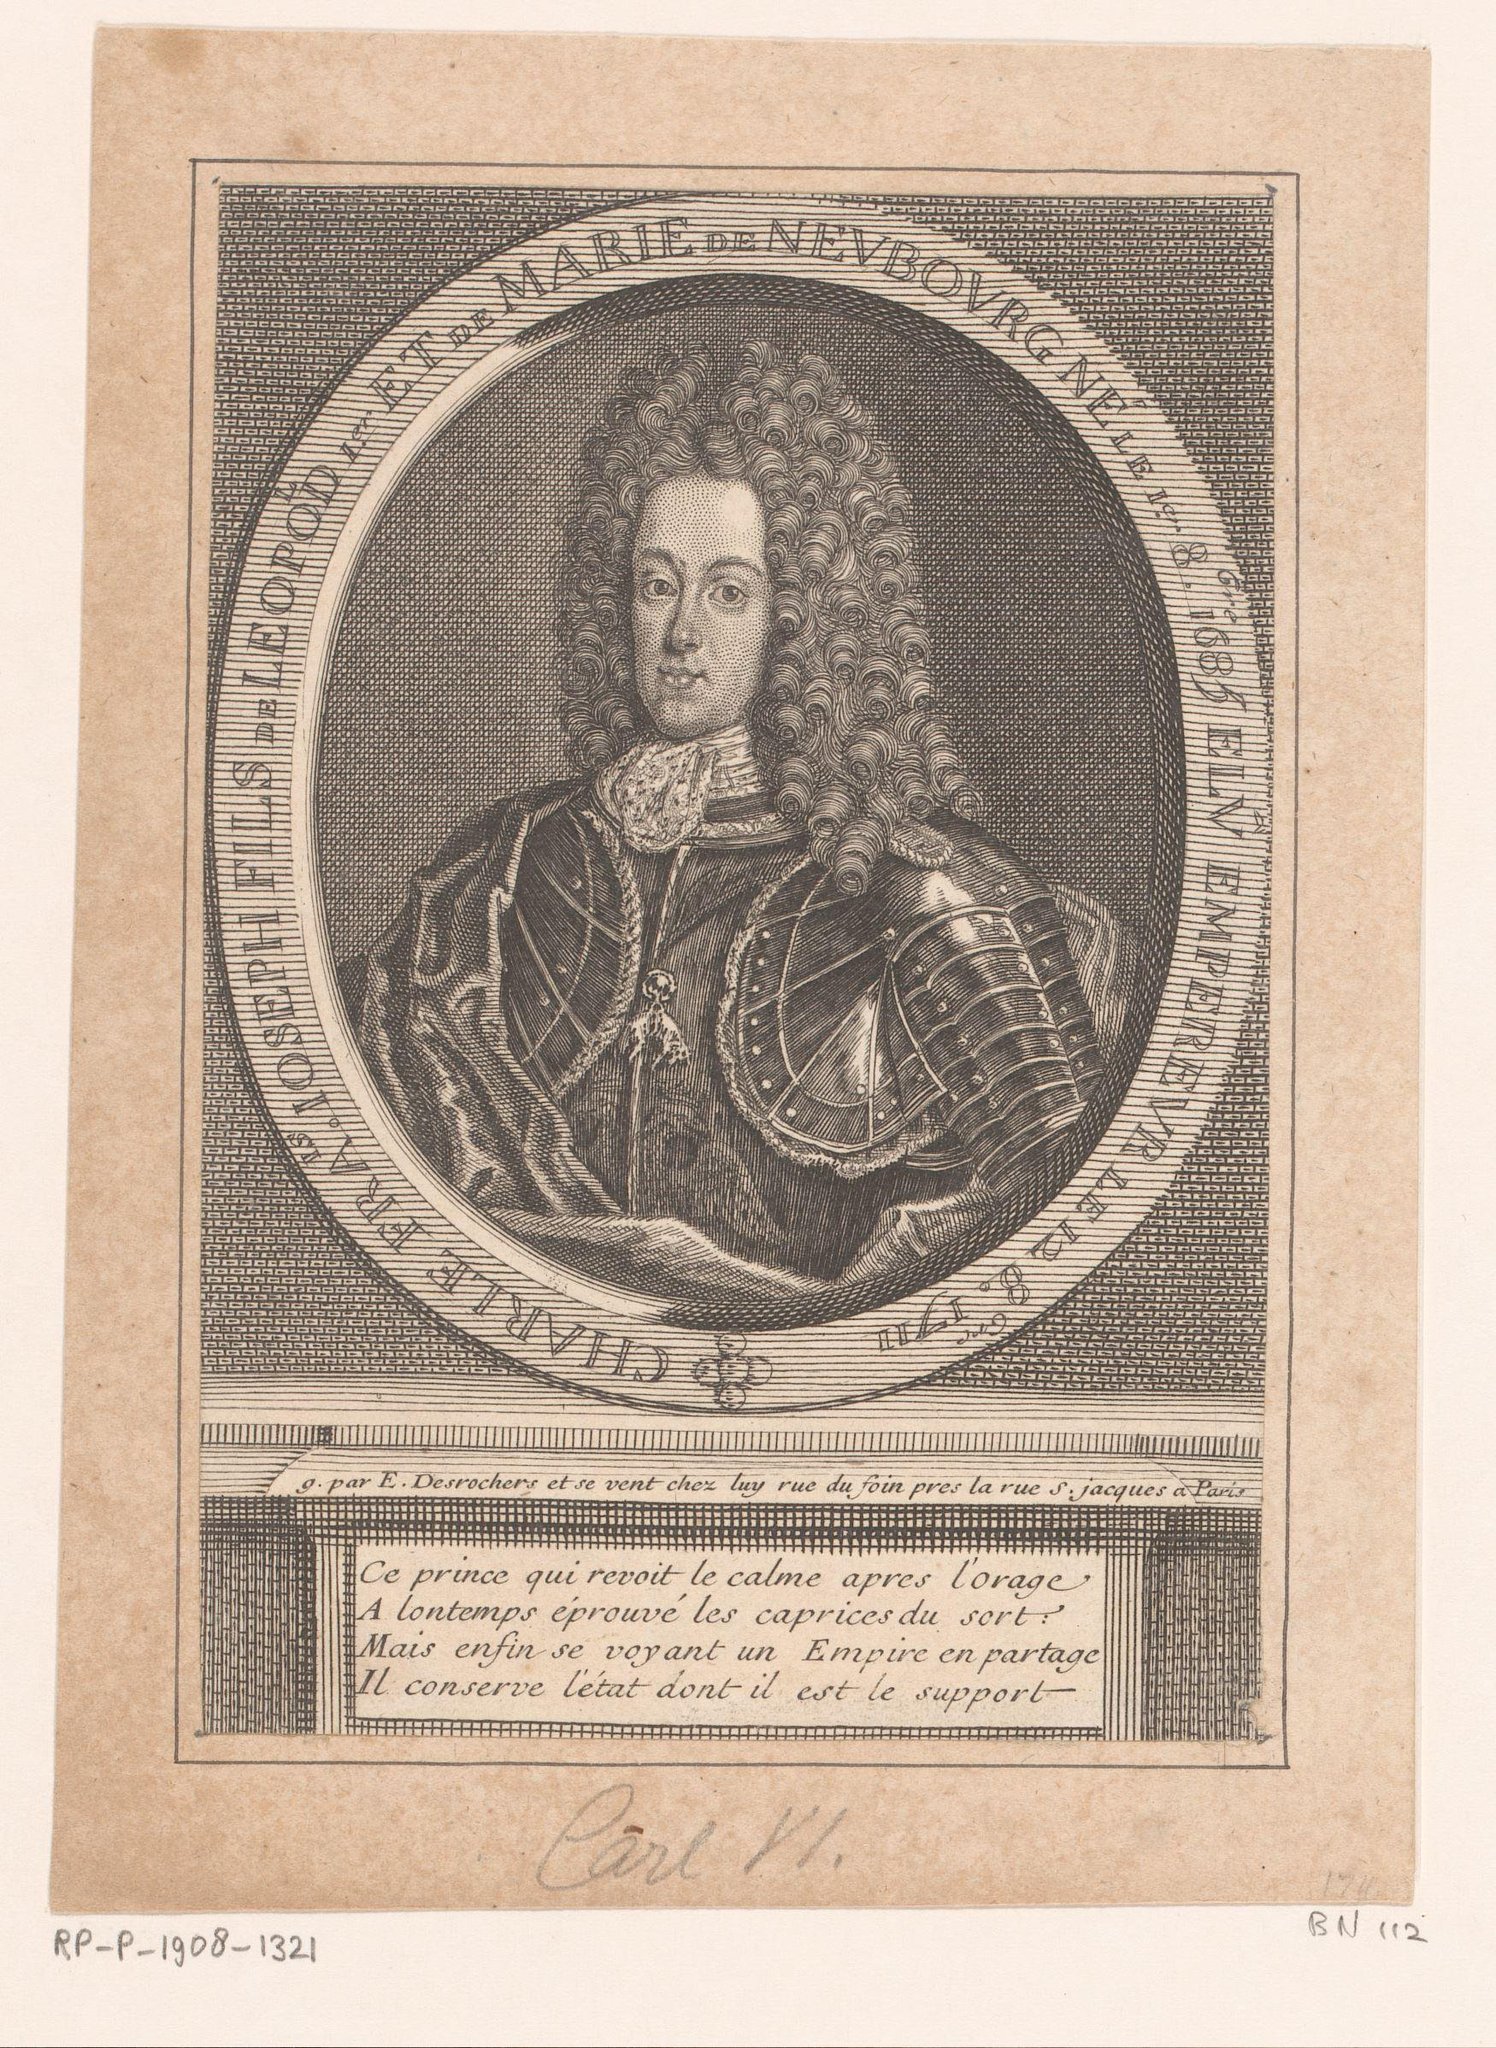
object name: print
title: Portret van keizer Karel VI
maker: étienne desrochers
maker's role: print maker, publisher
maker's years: 1668-1741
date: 1726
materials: paper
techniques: engraving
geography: paris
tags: vienna, charles vi (holy roman emperor), historical persons, emperor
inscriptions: number: ‘No. 5.’, collector's mark: Lugt 2228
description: Behoort waarschijnlijk tot een serie portretten, grotendeels door Etienne Desrochers, getiteld: 'Recueil de portraits de personnes qui se sont distinguées tant dans les Armes que dans Belles-Lettres et les Arts, comme aussi la famille royale de France et autres cours étrangères'. De serie werd initieel uitgegeven door Desrochers en aangekondigd in 'Mercure' in mei 1726, p. 985. Echter was Desrochers reeds enkele jaren eerder begonnen met het uitgeven van de serie. Na de dood van Desrochers werd de serie voortgezet door Gilles Edme Petit. Een latere staat werd uitgegeven door Jean François Daumont in Parijs.